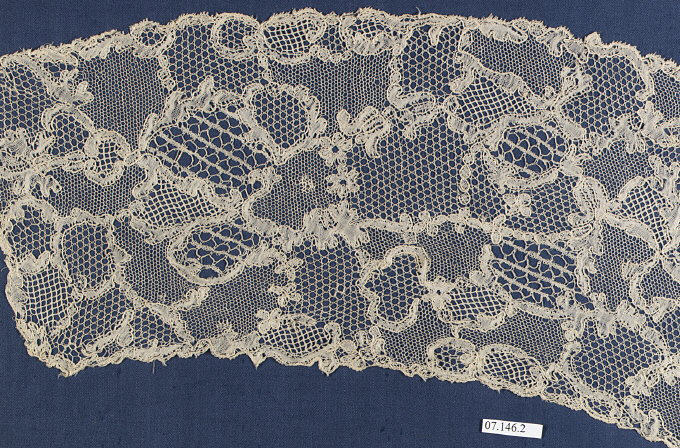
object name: fragment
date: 1801-1833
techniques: lace